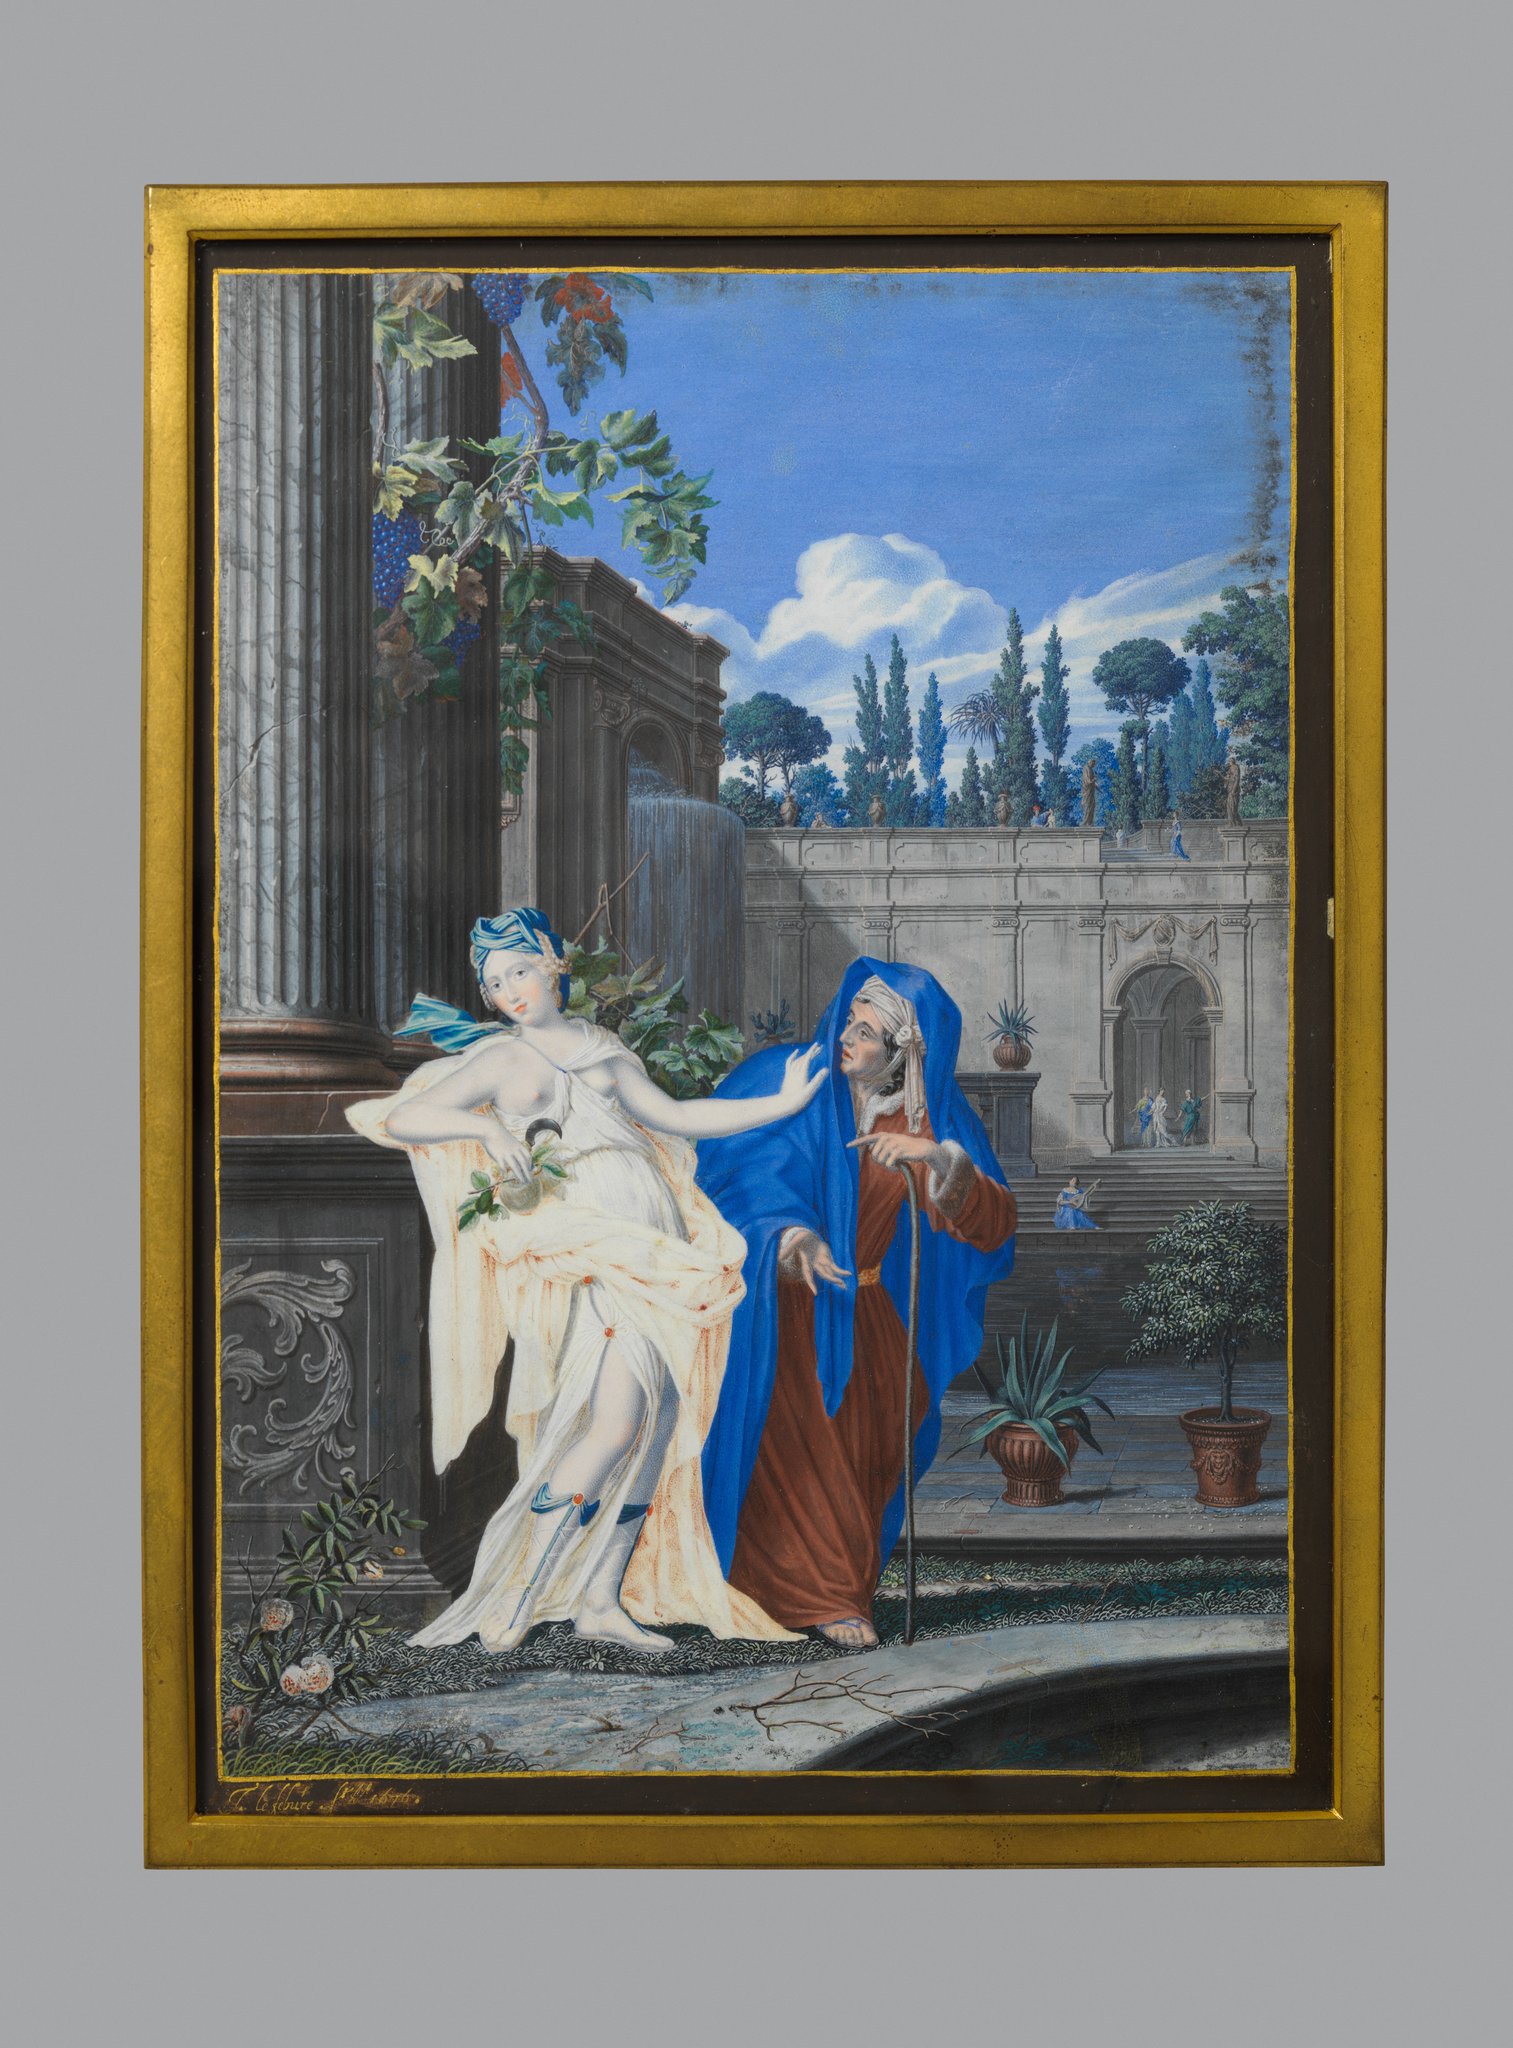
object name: painting, miniature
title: Vertumnus and Pomona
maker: thomas lefebure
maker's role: artist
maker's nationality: flemish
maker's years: 1636-1720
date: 1676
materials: paper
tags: gardens,women